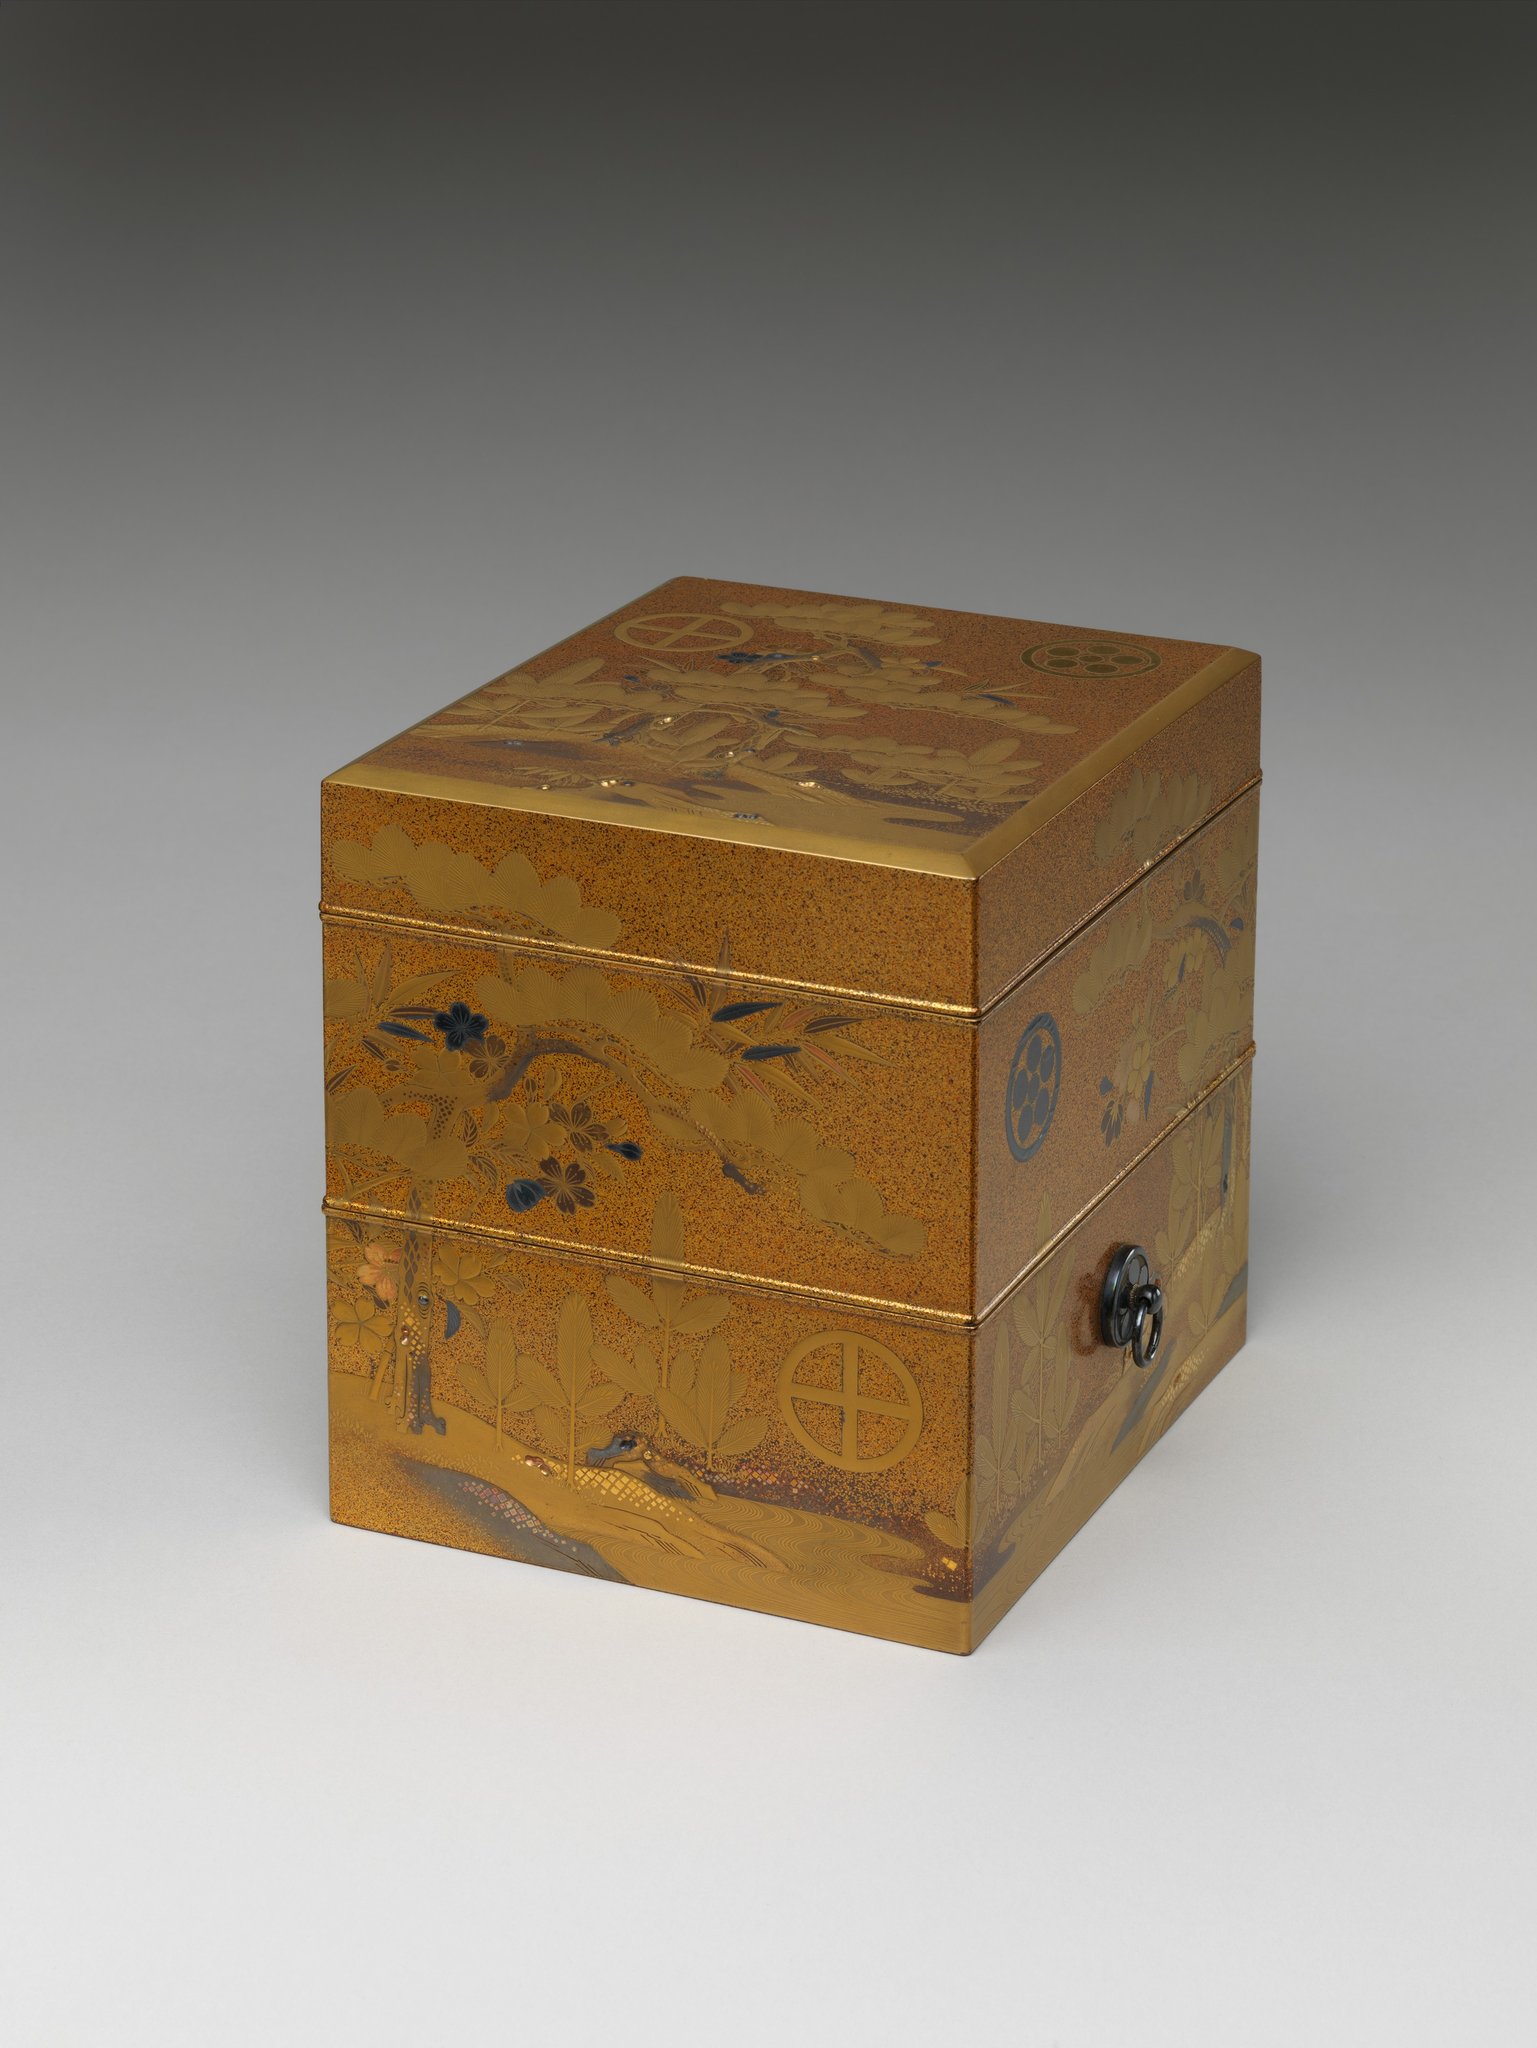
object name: box with lid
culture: japanese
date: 1801-1900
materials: gold, lacquer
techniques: maki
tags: trees